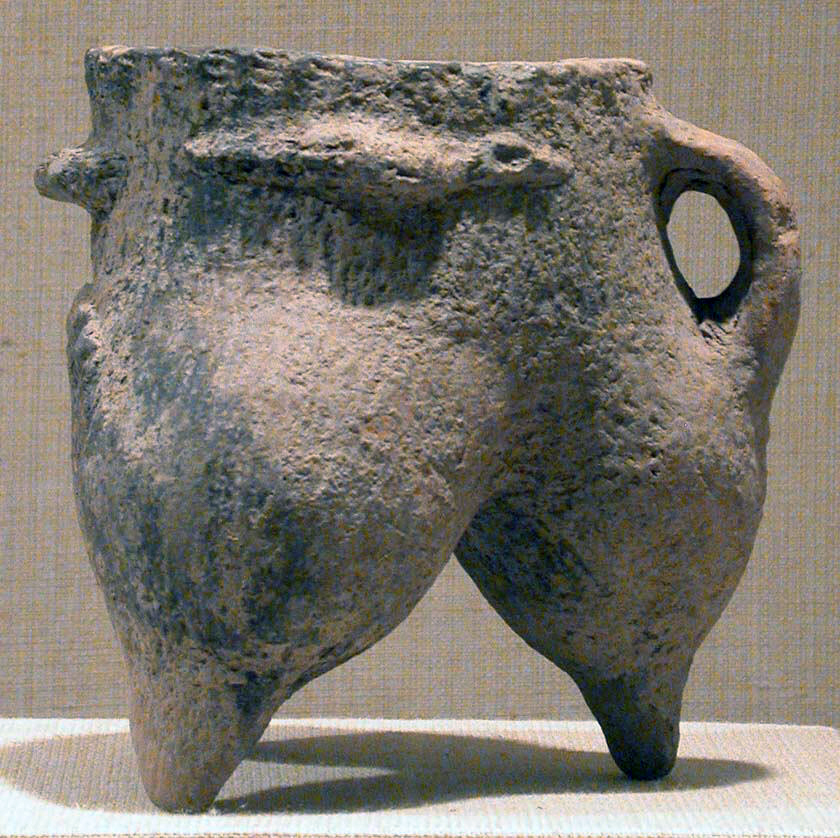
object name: tripod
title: Tripod (Li)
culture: chinese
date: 1100-1001 BCE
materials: cord, earthenware, pigment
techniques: appliqué